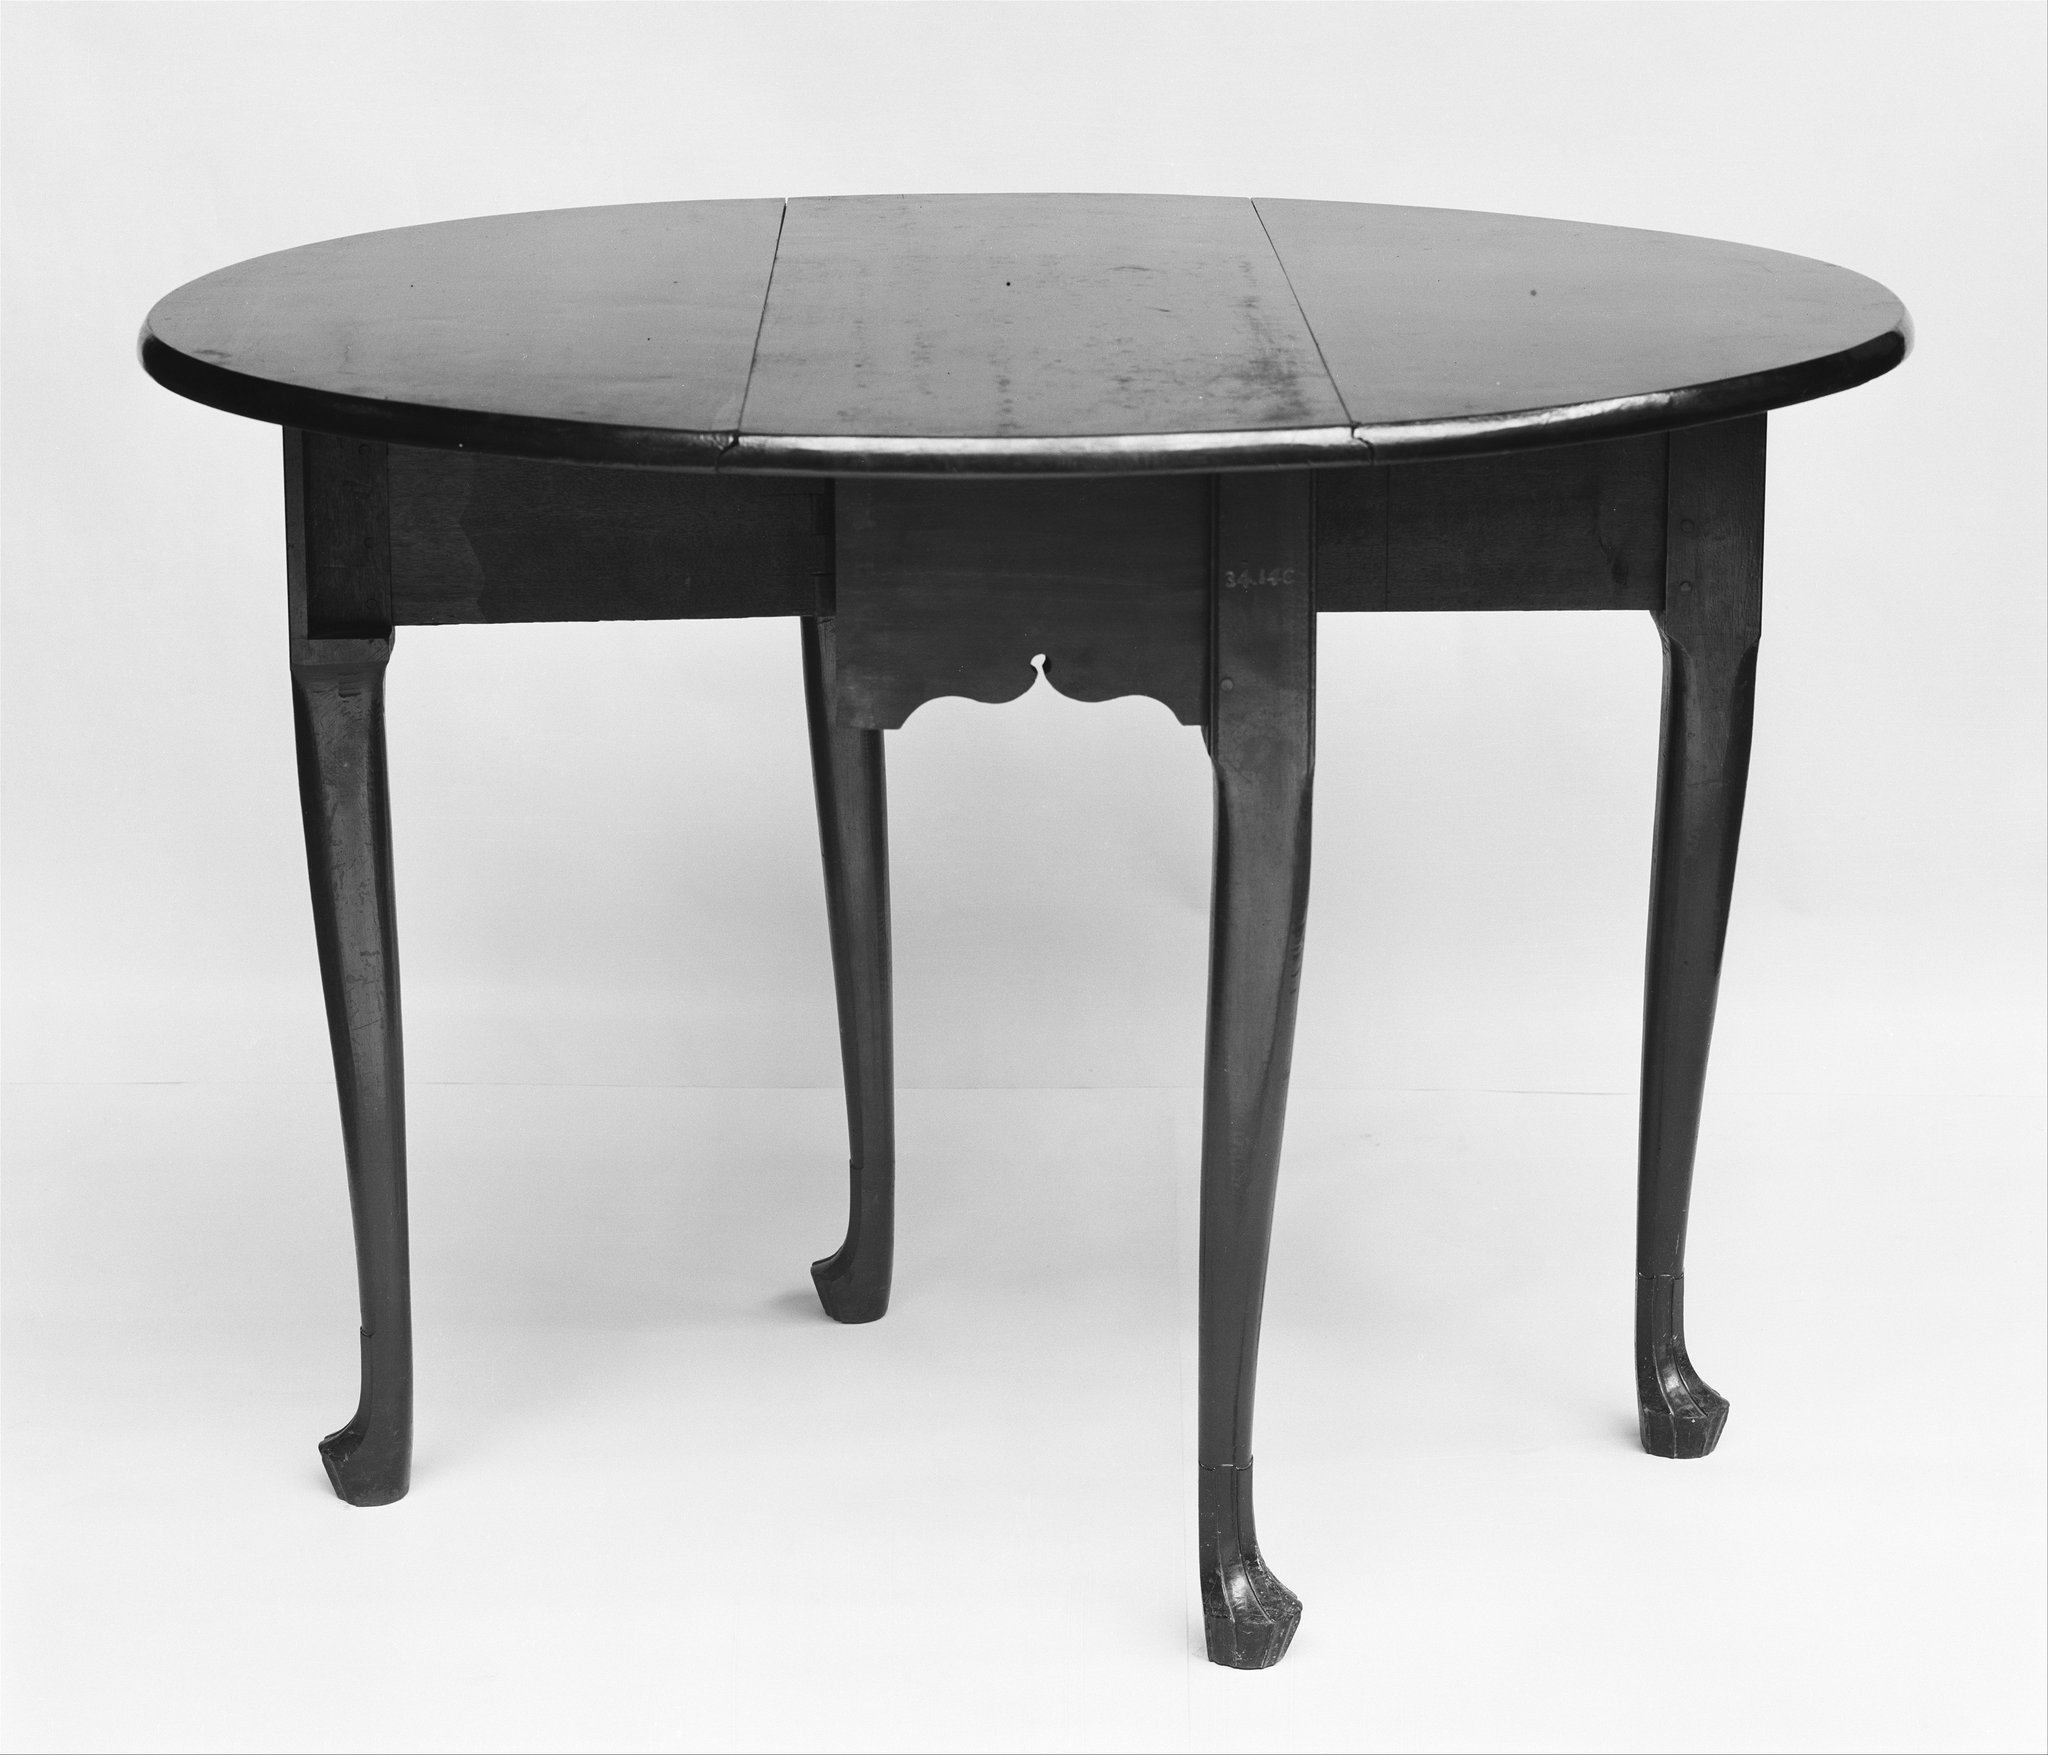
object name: drop leaf dining table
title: Drop-leaf Dining Table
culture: american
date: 1740-1790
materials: wood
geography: united states